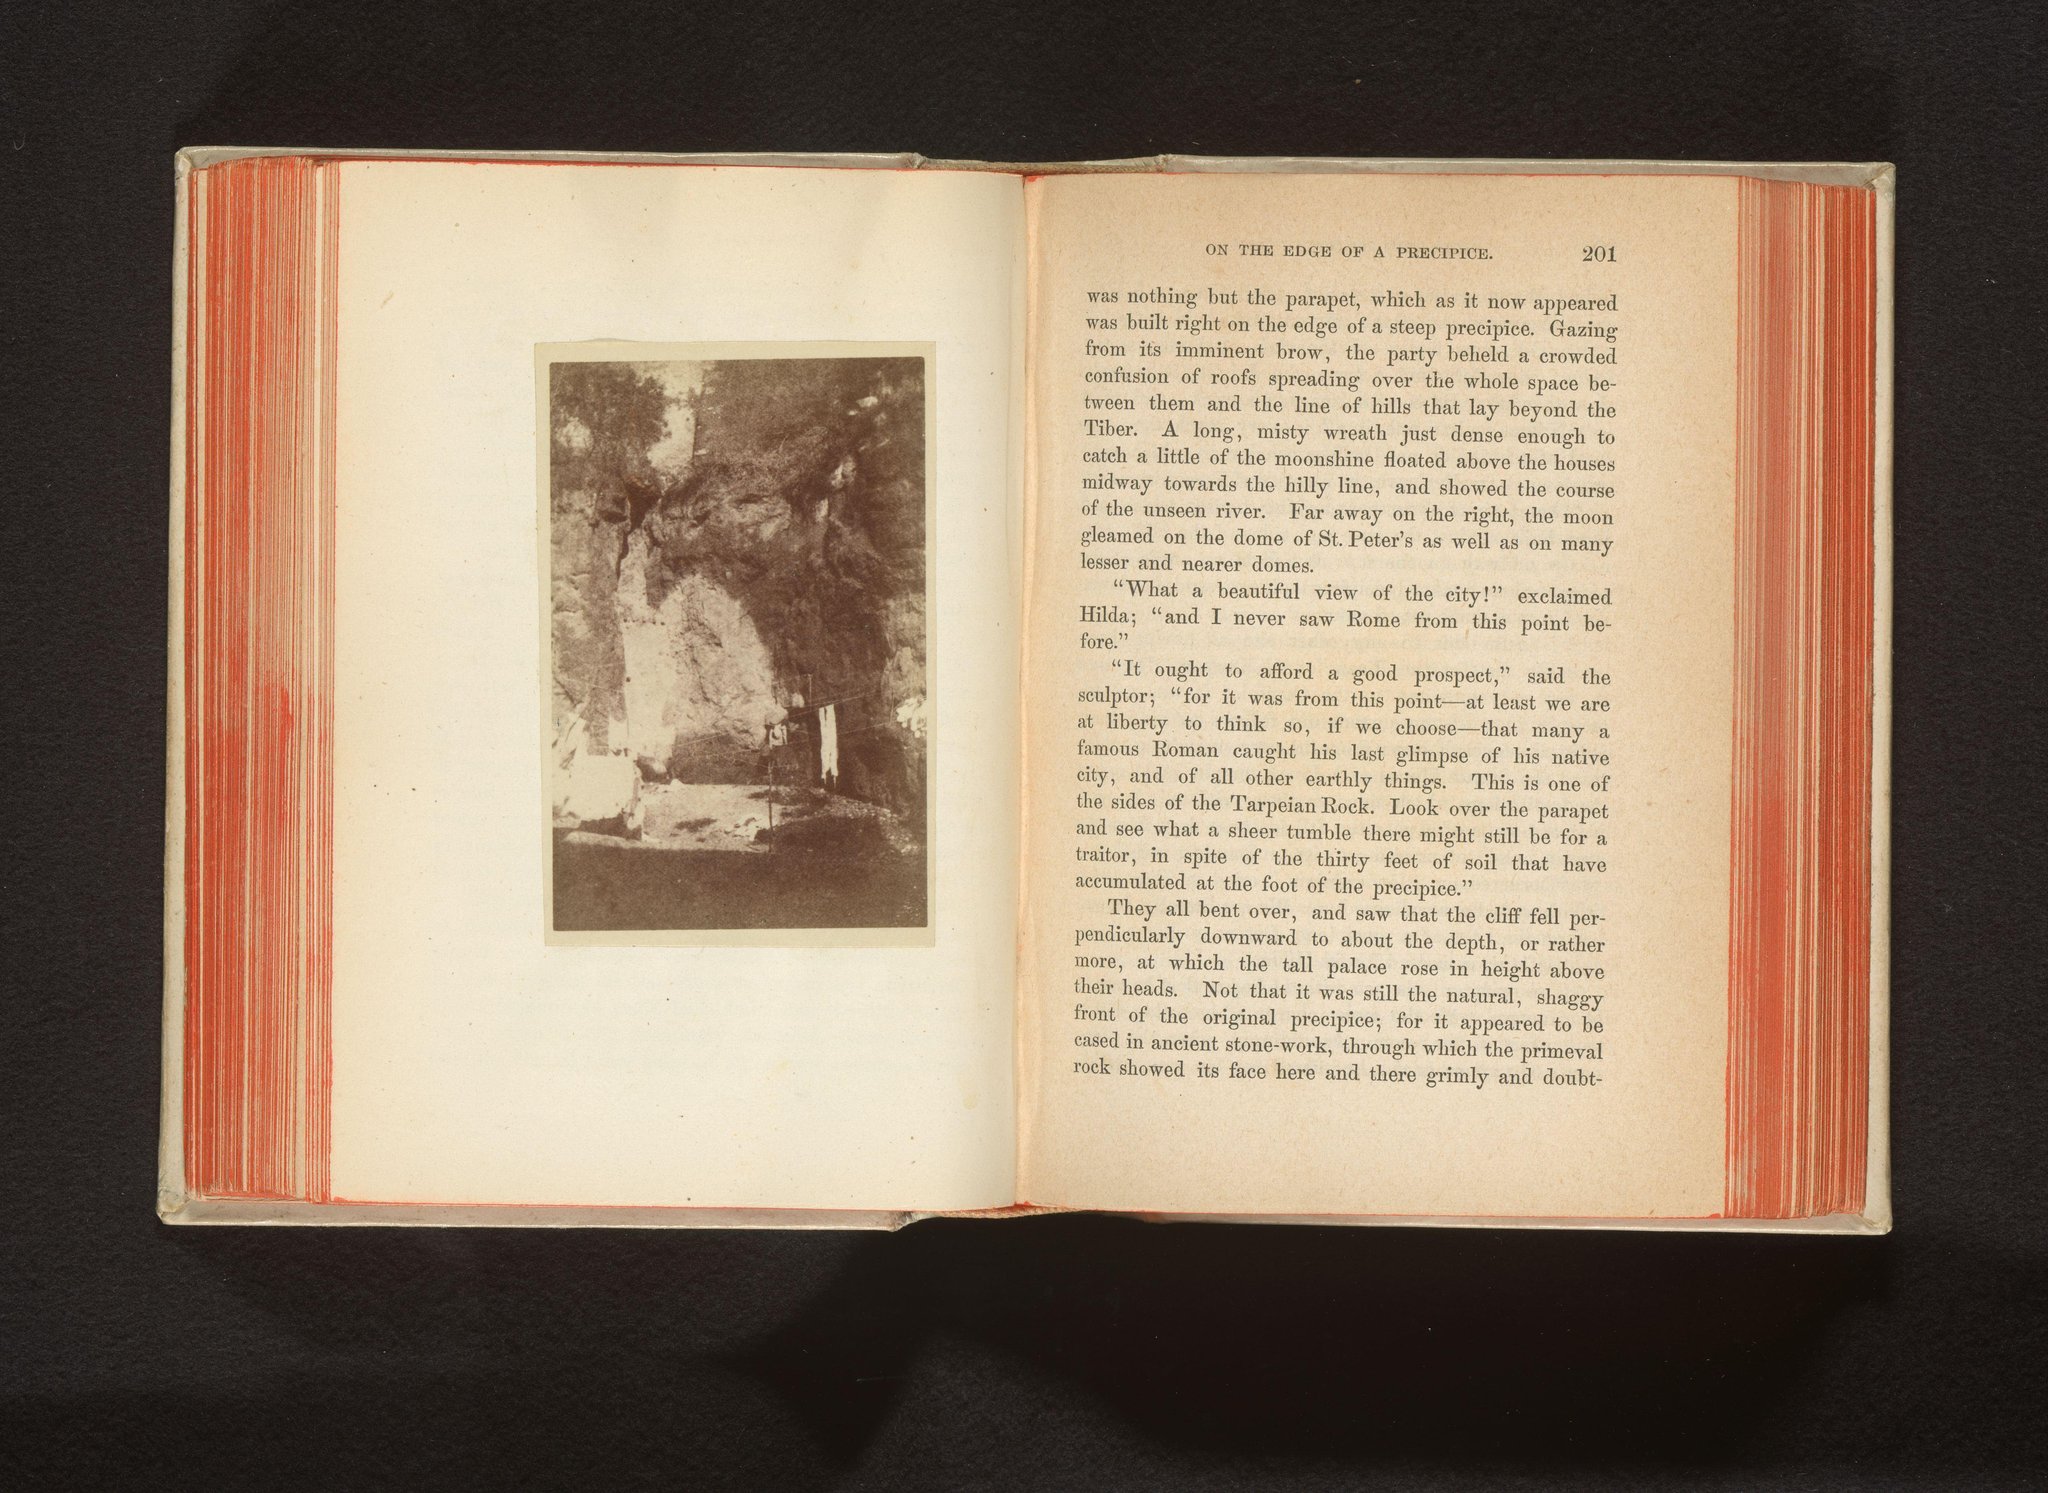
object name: photograph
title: Gezicht op de Tarpeïsche rots in Rome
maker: Anonymous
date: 1850-1860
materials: photographic support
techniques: albumen print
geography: rome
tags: rock-formations